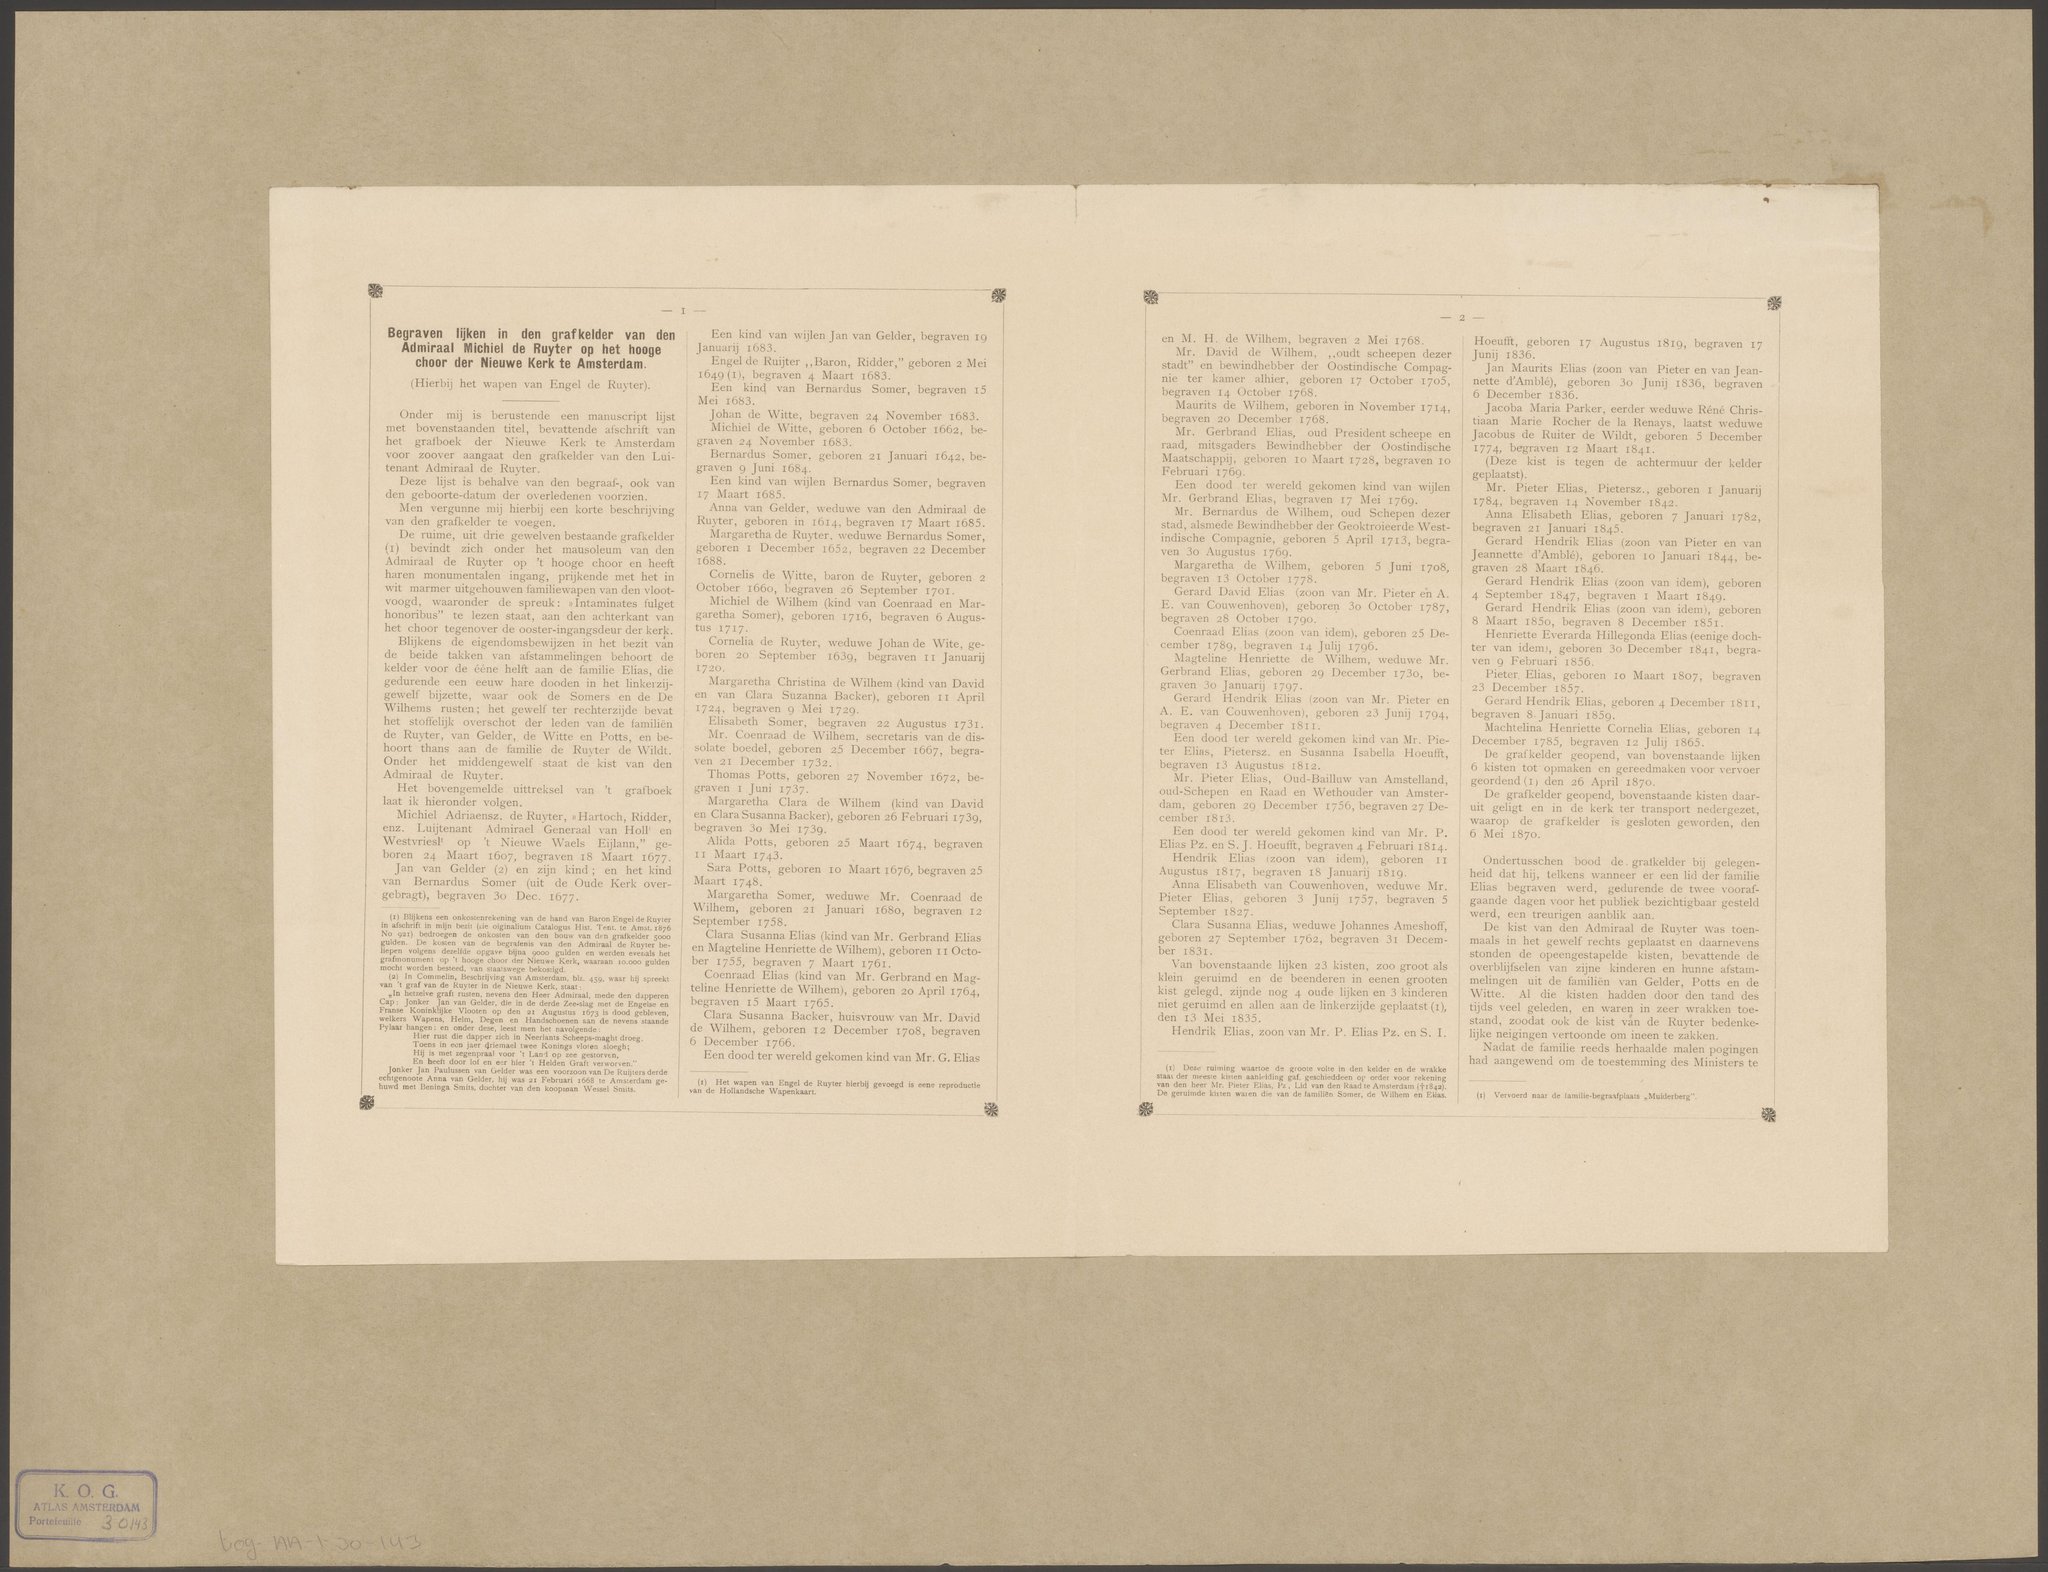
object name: text sheet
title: Begraven lijken in den grafkelder van den Admiraal Michiel de Ruyter op het hooge choor der Nieuwe Kerk te Amsterdam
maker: johan engelbert elias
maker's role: historicus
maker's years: 1875-1959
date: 1895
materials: paper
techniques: letterpress printing, printing block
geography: oisterwijk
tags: parts of church interior (crypt)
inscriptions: collector's mark: Lugt 1641b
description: Tekst uit: Elias, Johan Engelbert. Grafkelder van den Admiraal Michiel de Ruyter. Oisterwijk: Genealogisch en Heraldisch Archief, 1895, p. 1-3.